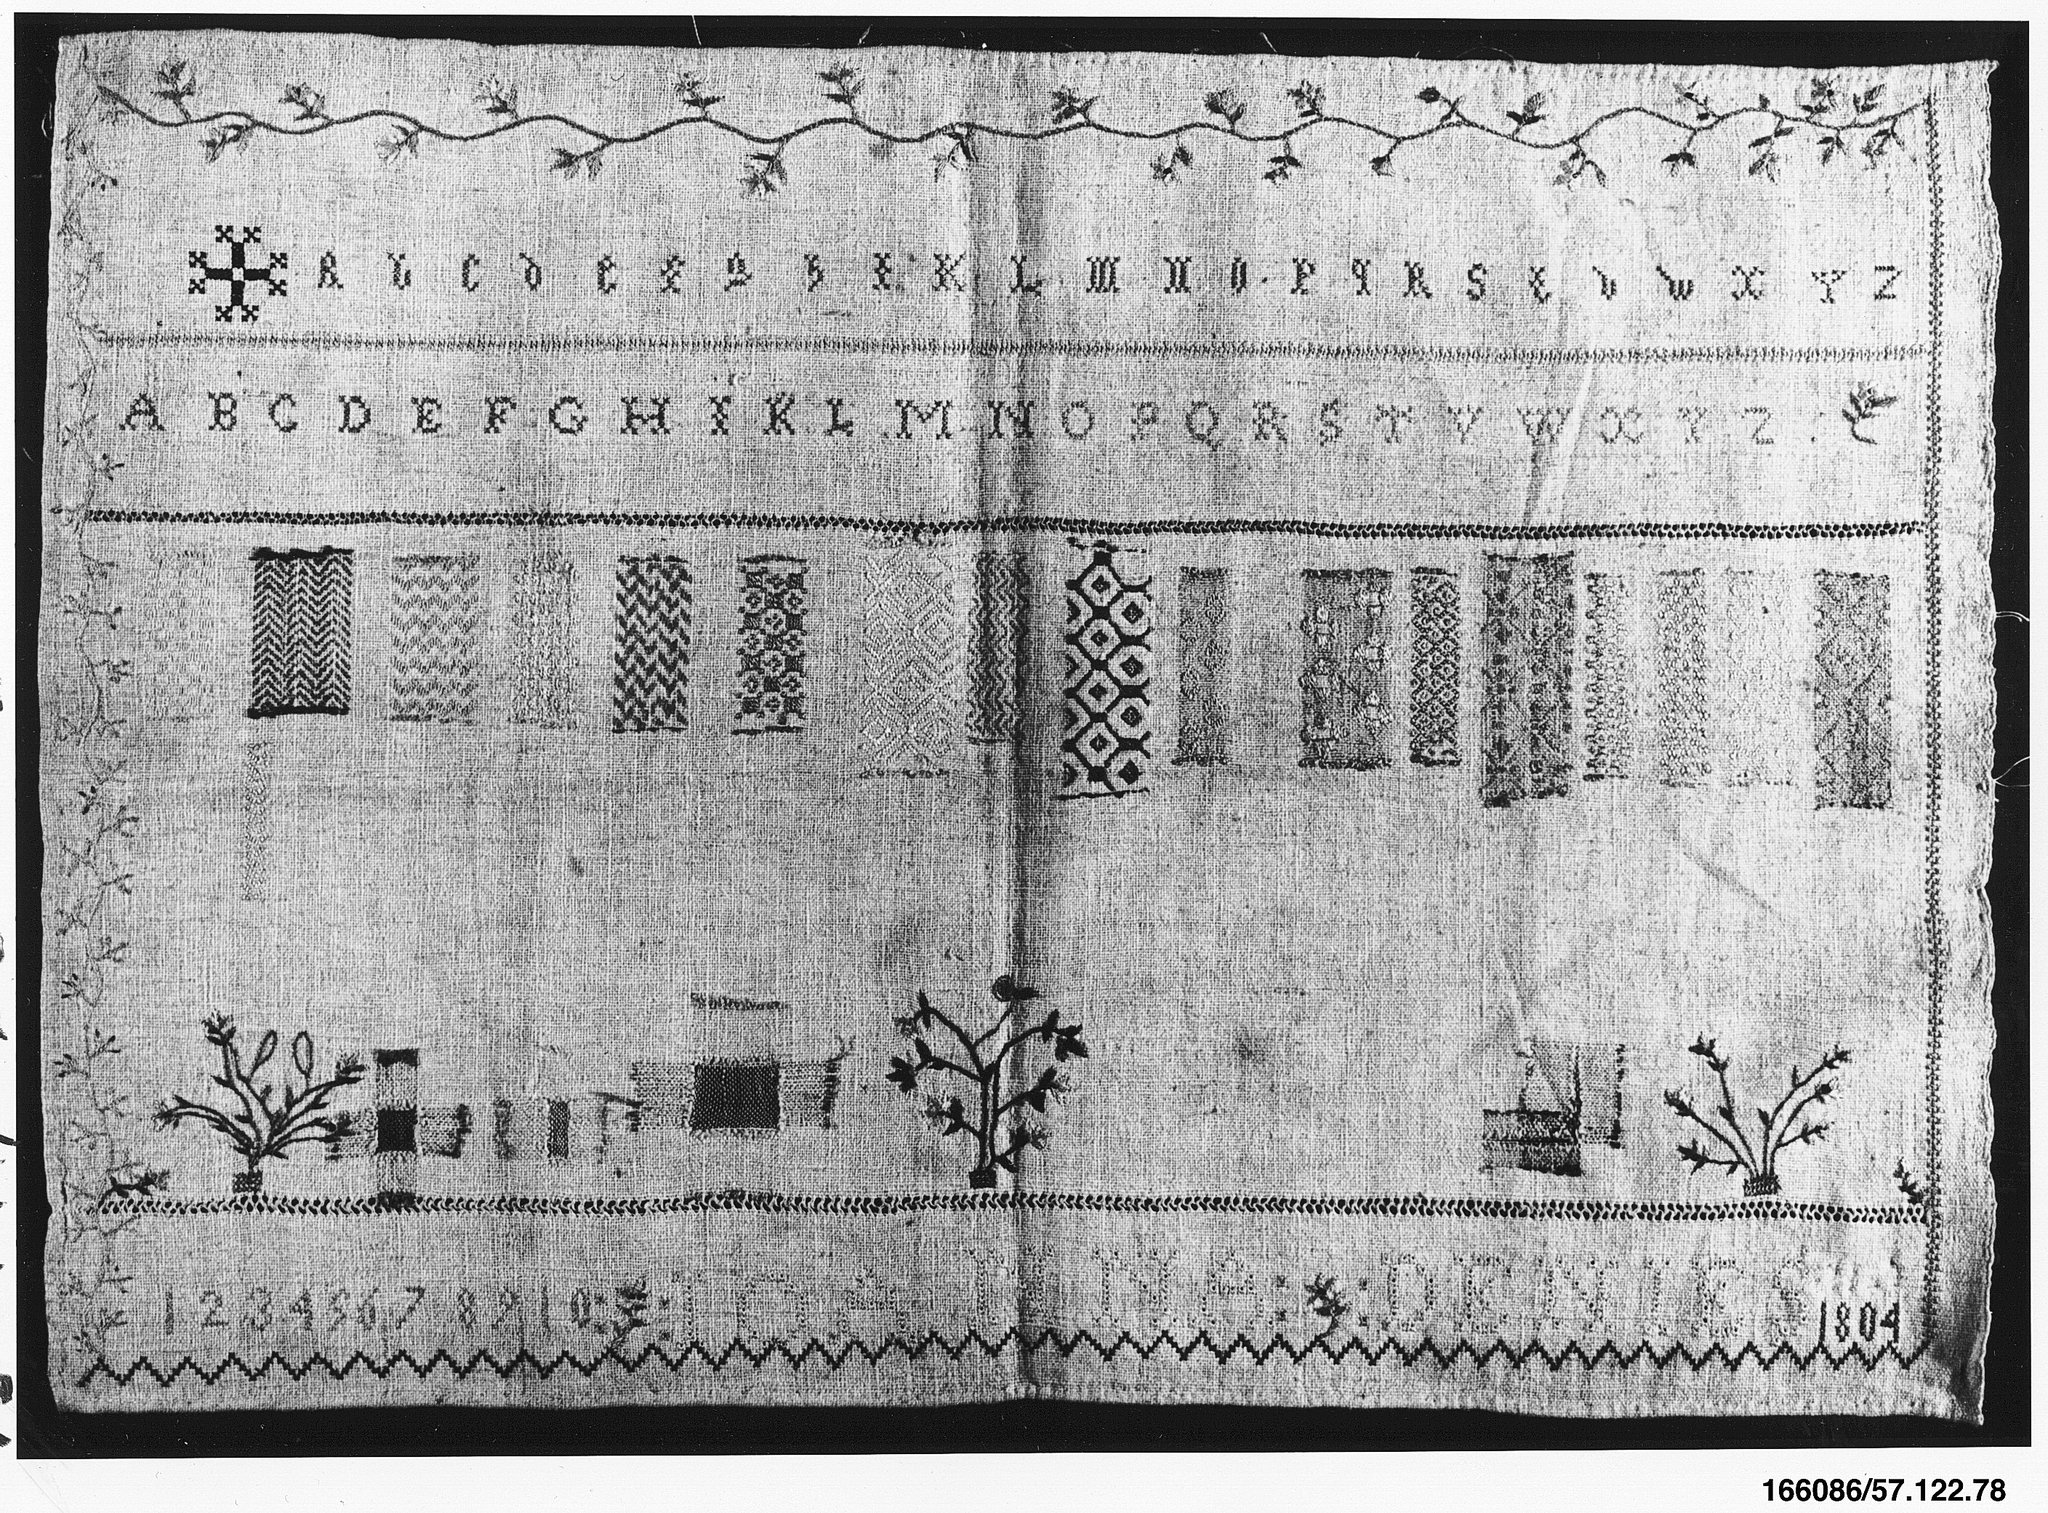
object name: sampler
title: Embroidered darning sampler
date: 1804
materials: cotton, silk